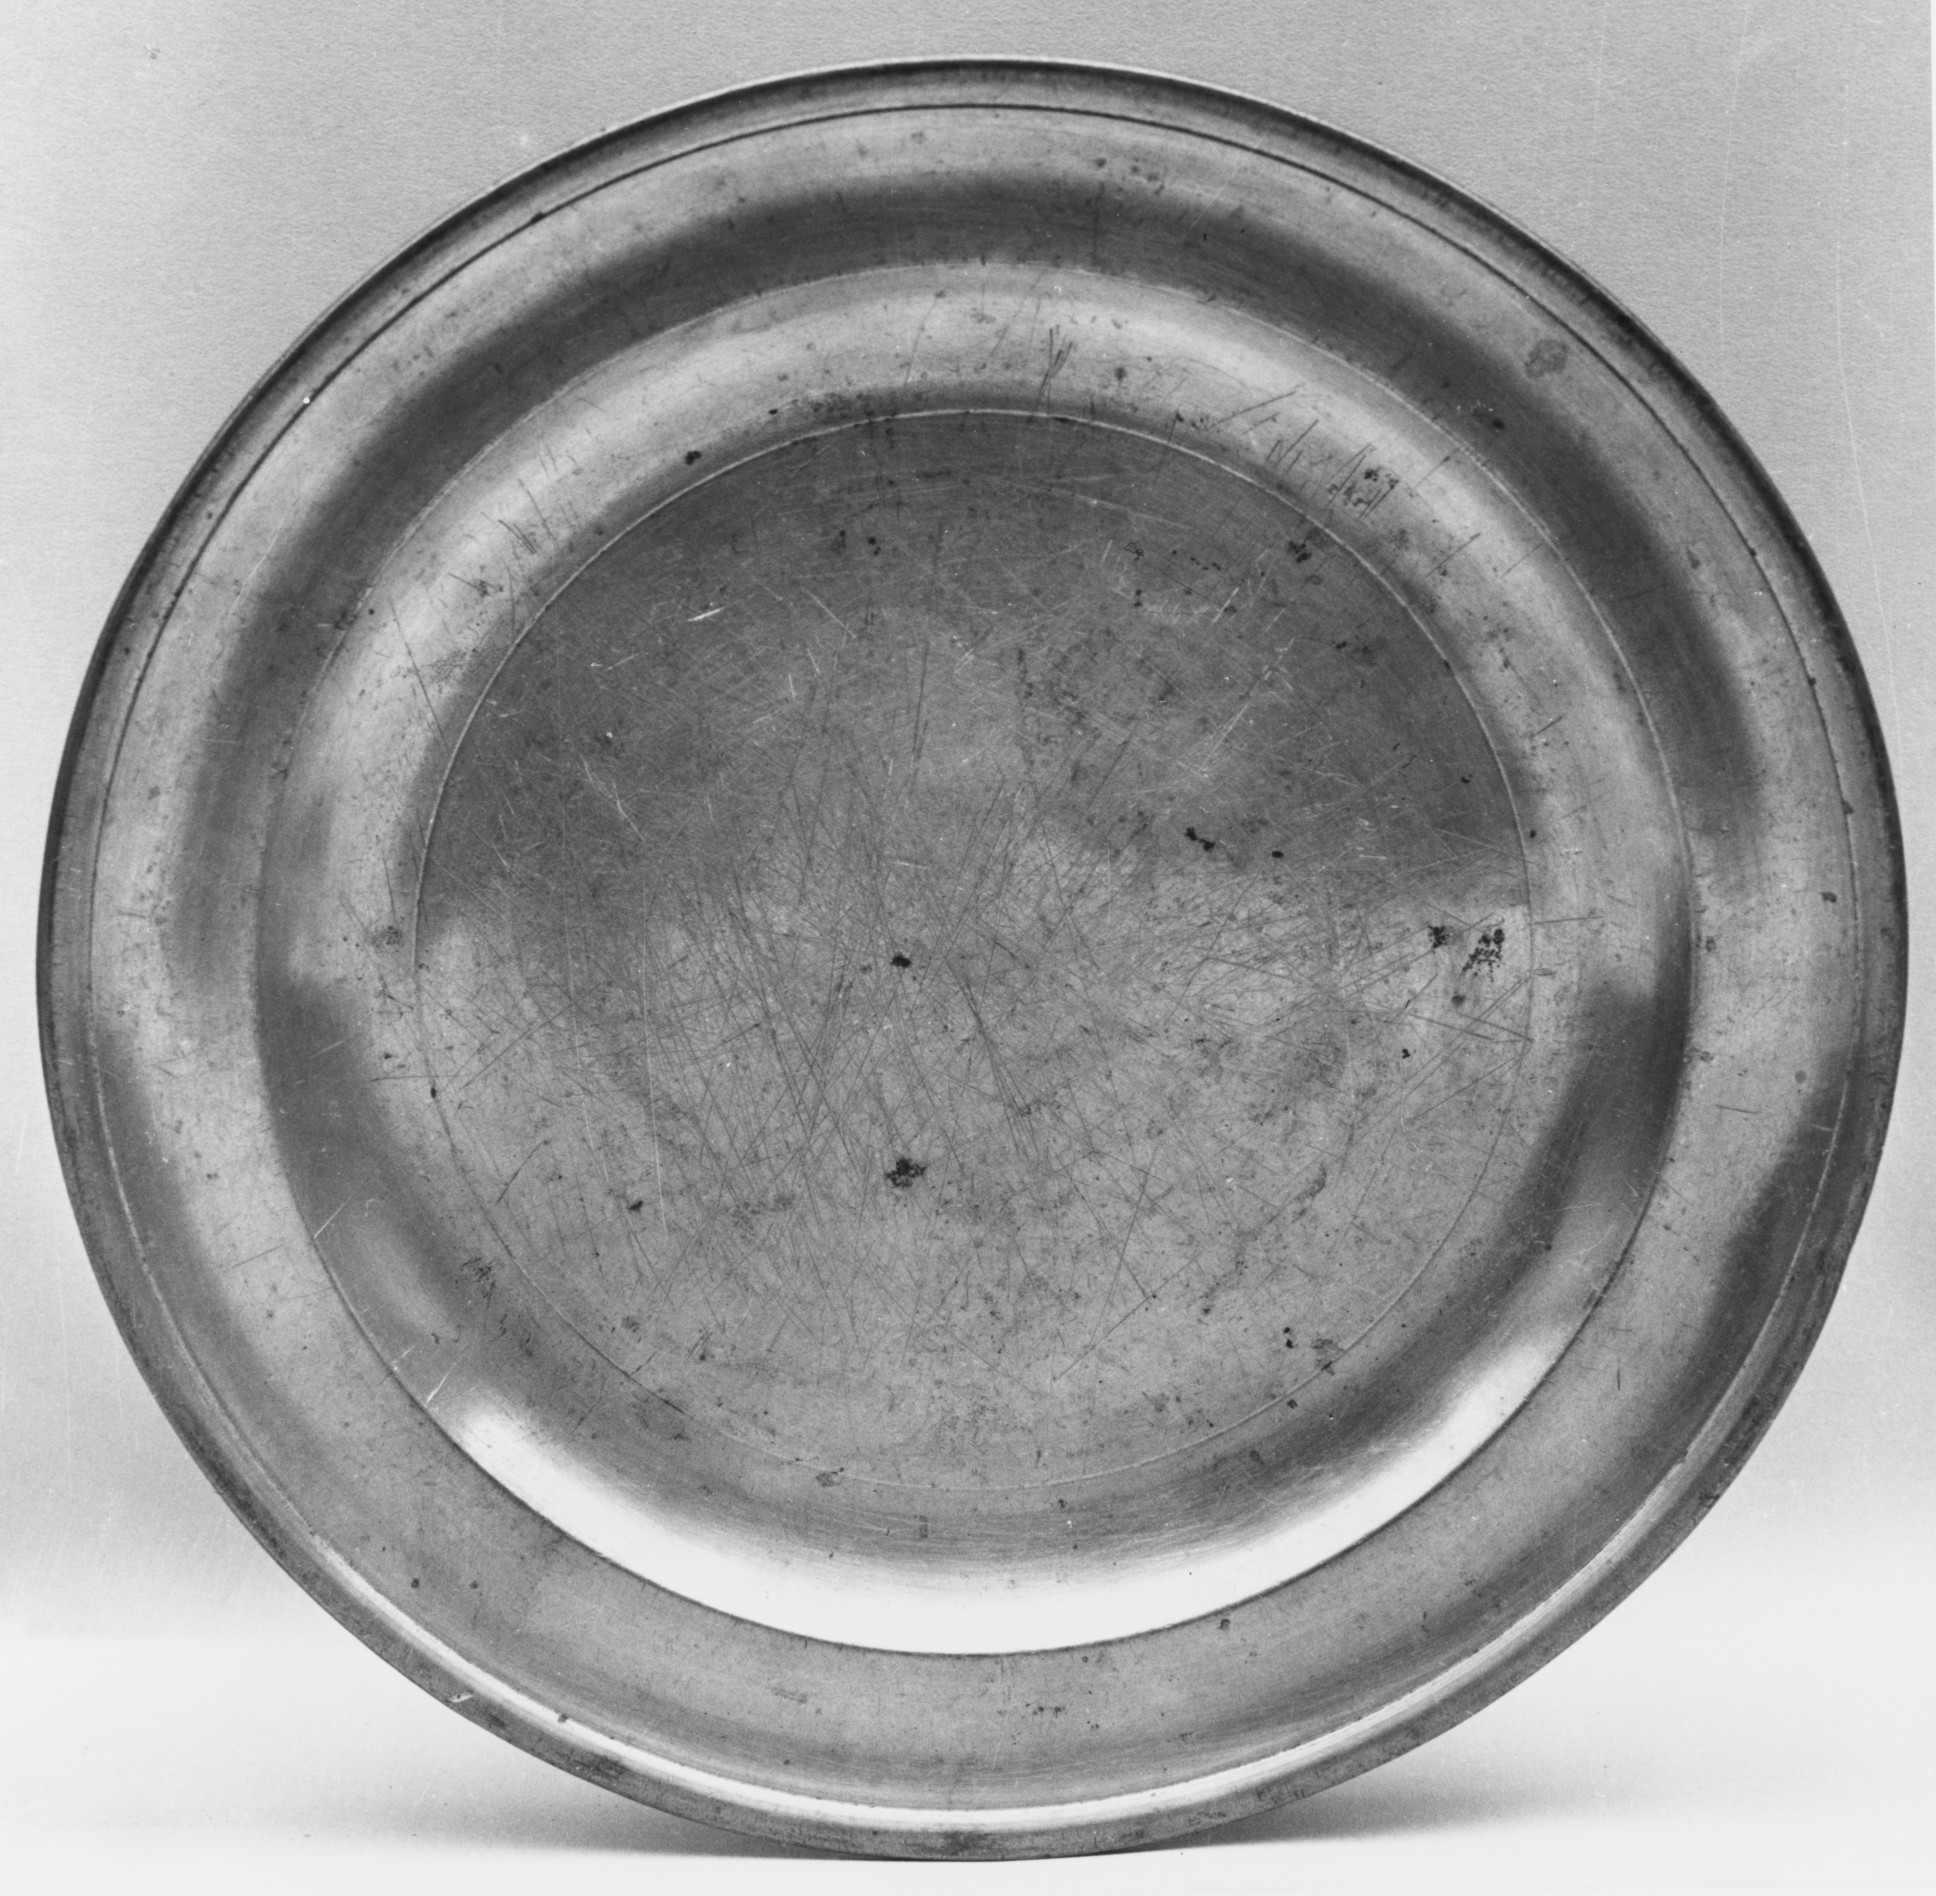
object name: plate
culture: american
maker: thomas badger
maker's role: maker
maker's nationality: american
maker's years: 1764-1826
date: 1787-1815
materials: pewter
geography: united states